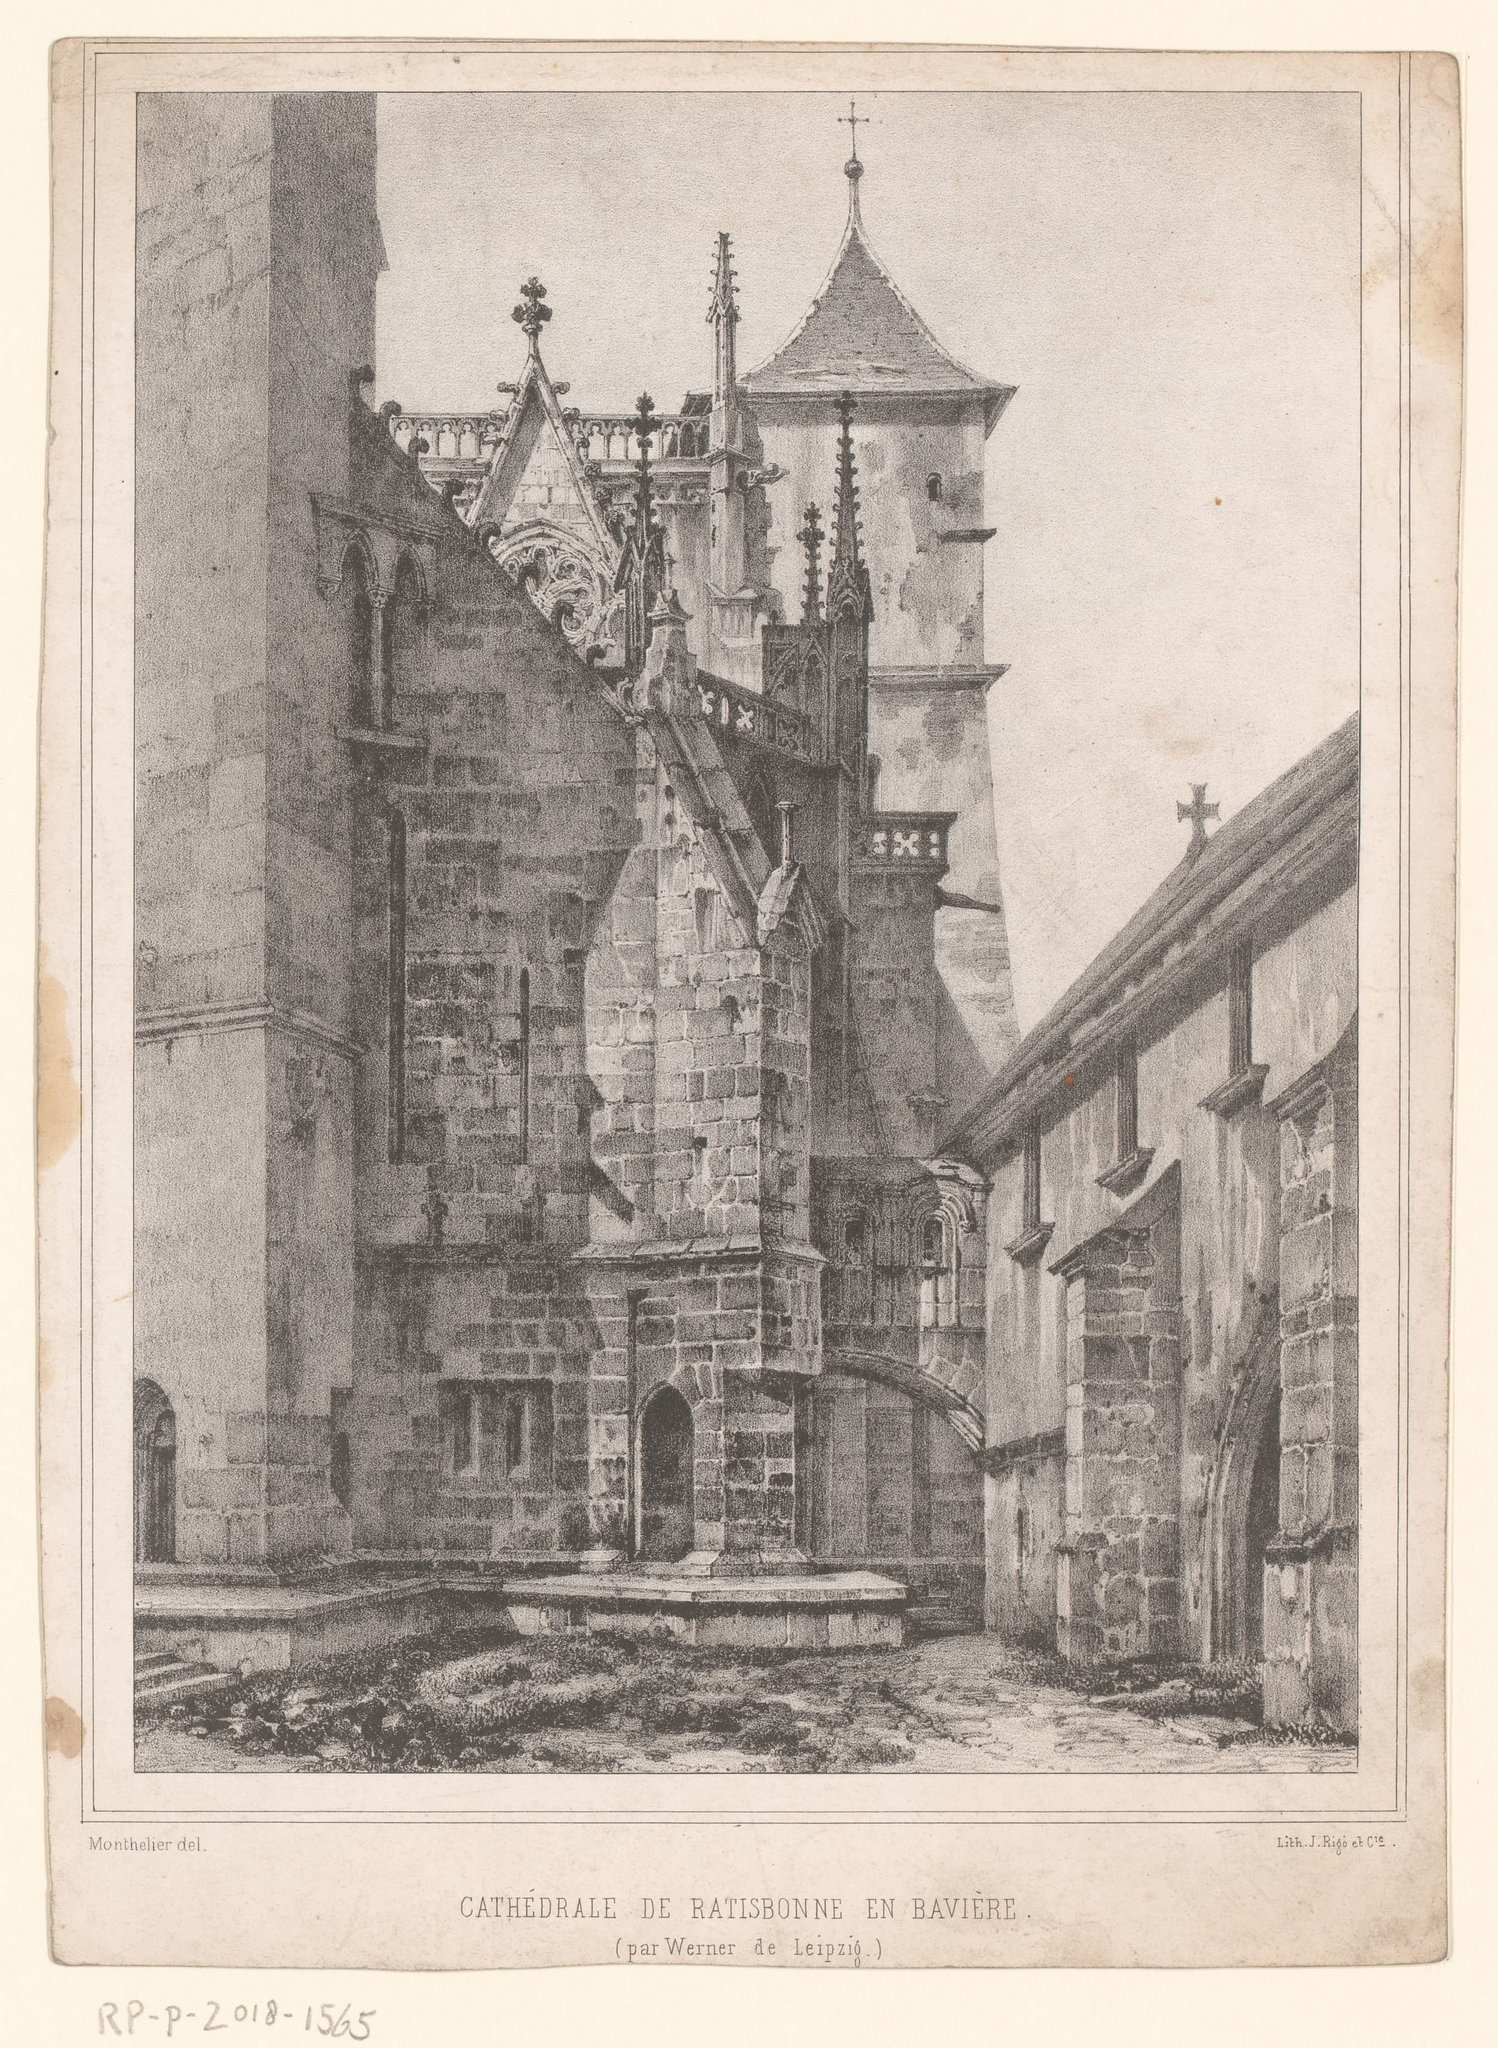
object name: print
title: Cathédrale de Ratisbonne en Bavière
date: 1800-1850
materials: paper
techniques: lithograph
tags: interior of church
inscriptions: collector's mark: Lugt 2228